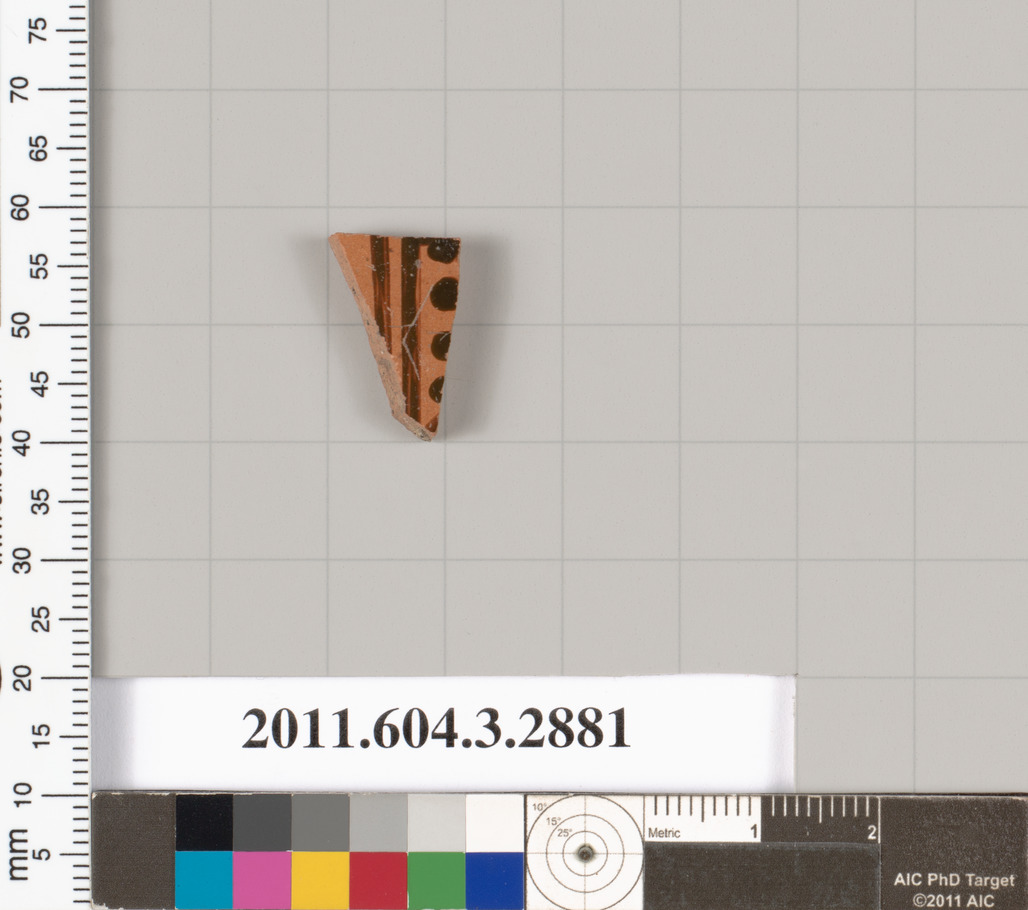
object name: olpe fragment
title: Terracotta fragment of an olpe (jug)?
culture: greek, attic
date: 534-468 BCE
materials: terracotta